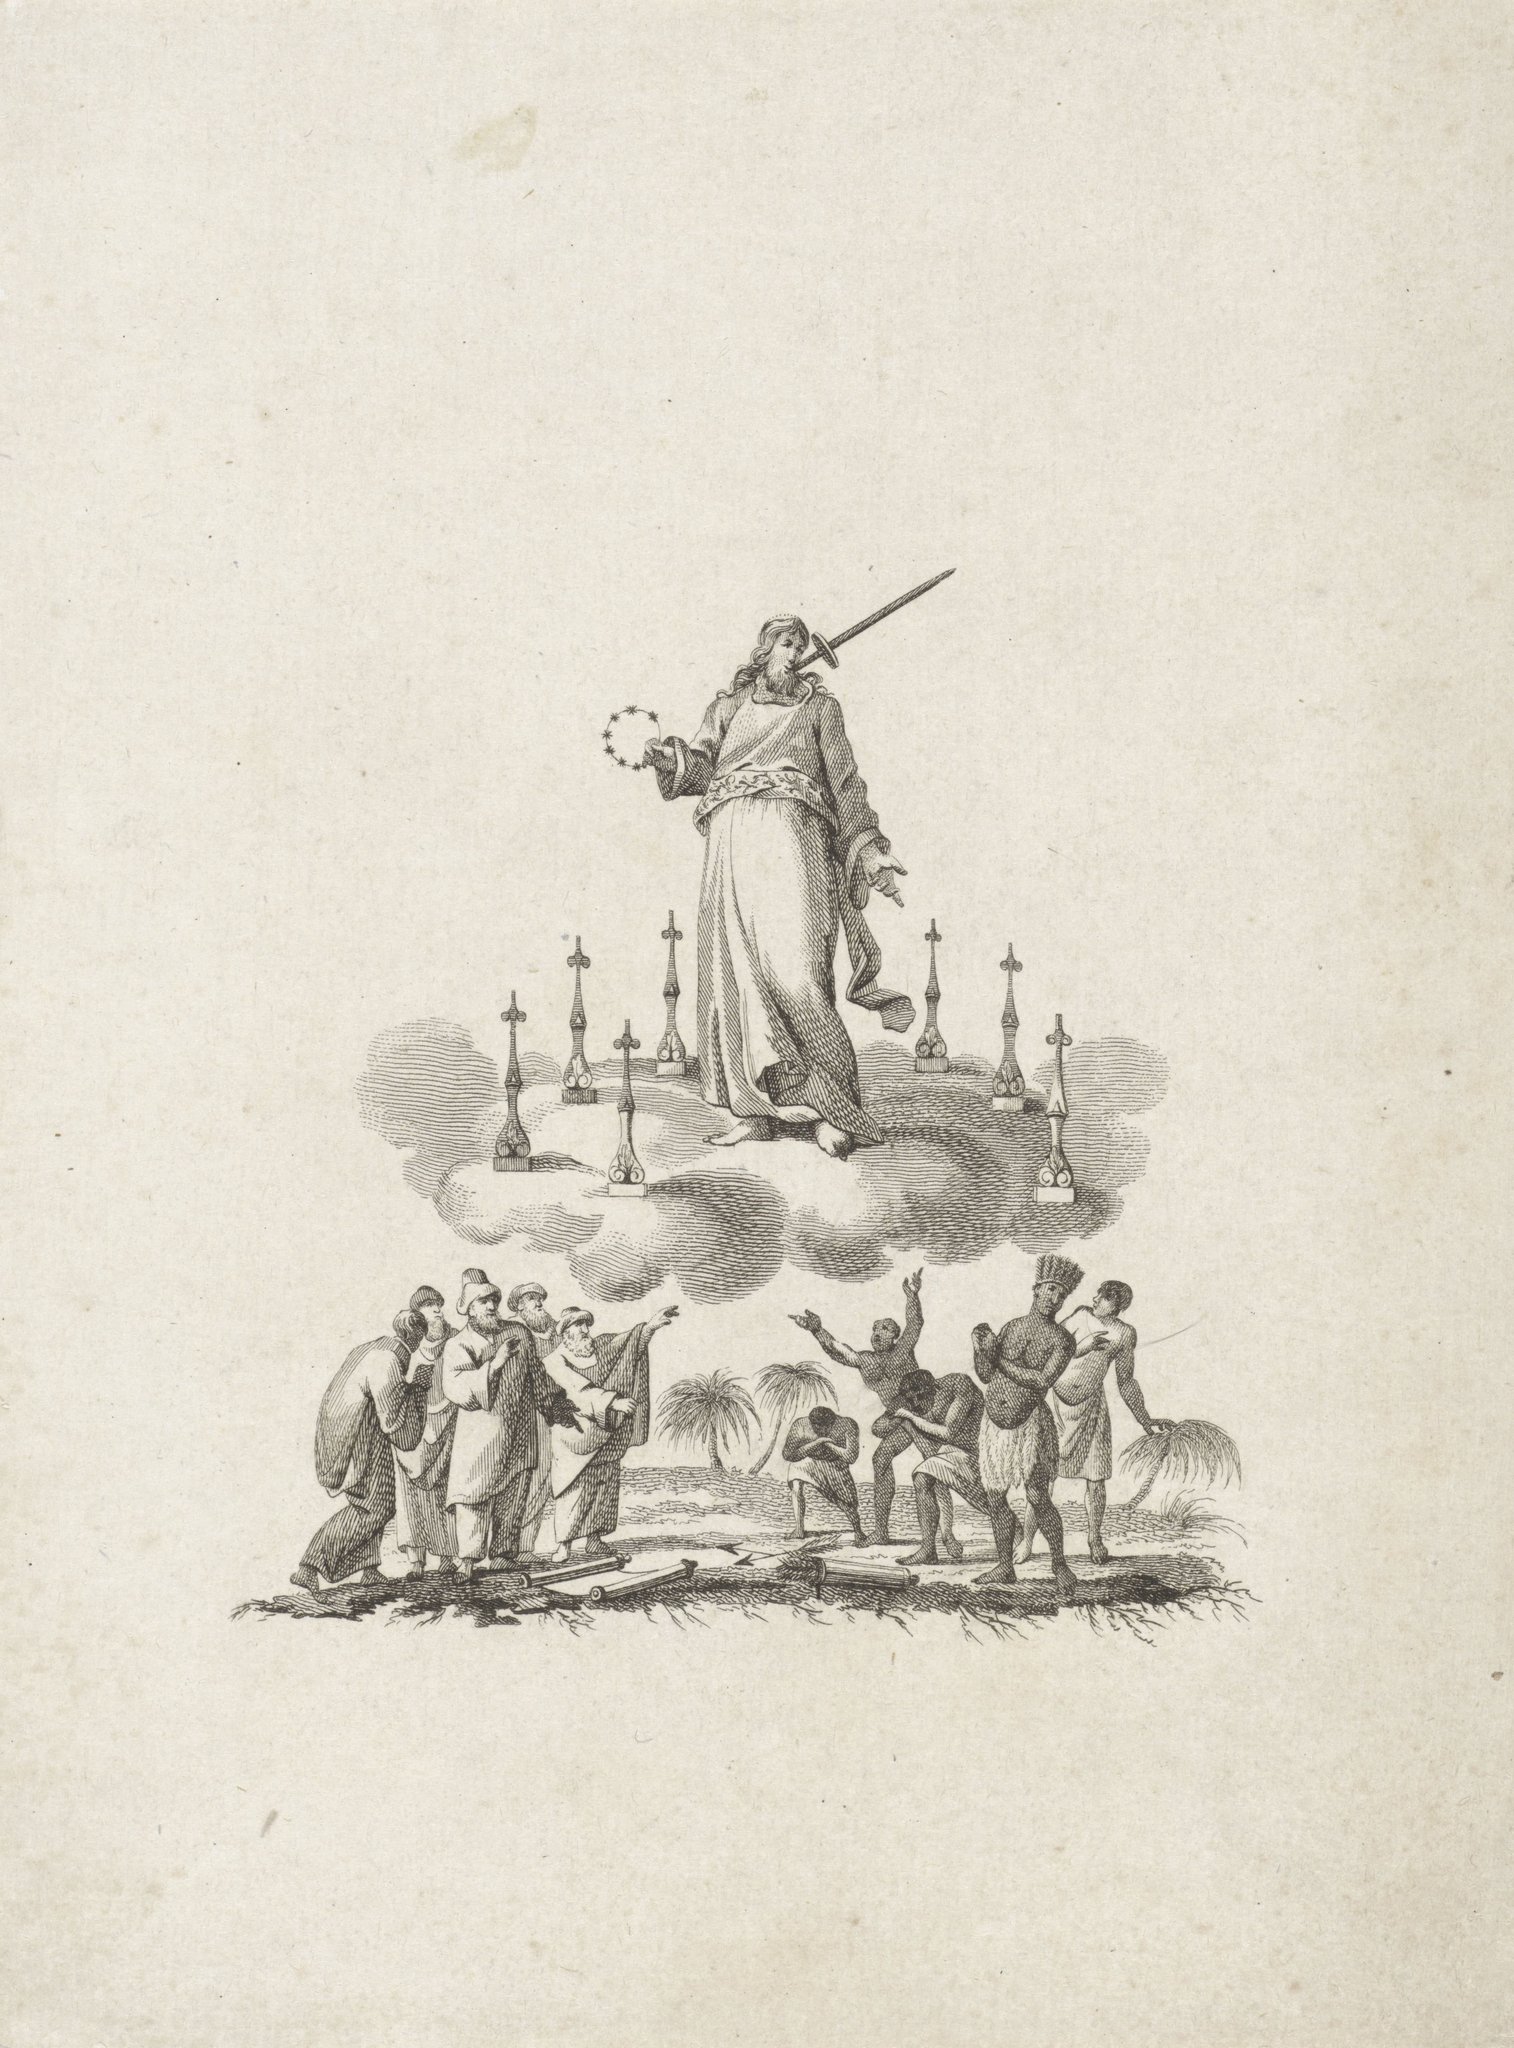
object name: print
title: Christus met zeven sterren en zwaard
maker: philippus velijn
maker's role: print maker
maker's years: 1787-1836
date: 1797-1836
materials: paper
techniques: etching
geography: netherlands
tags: christ between seven golden candlesticks appears to john, who falls to the ground; a sword comes out of christ's mouth and he holds seven stars in his hands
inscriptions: collector's mark: Lugt 2228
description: Christus tussen de wolken, tussen zeven kandelaars, met in zijn hand zeven sterren en uit zijn mond een tweesnijdende zwaard. Illustratie het Bijbelverhaal van het visioen van Johannes op het eiland Patmos (Op. 1: 12-16).